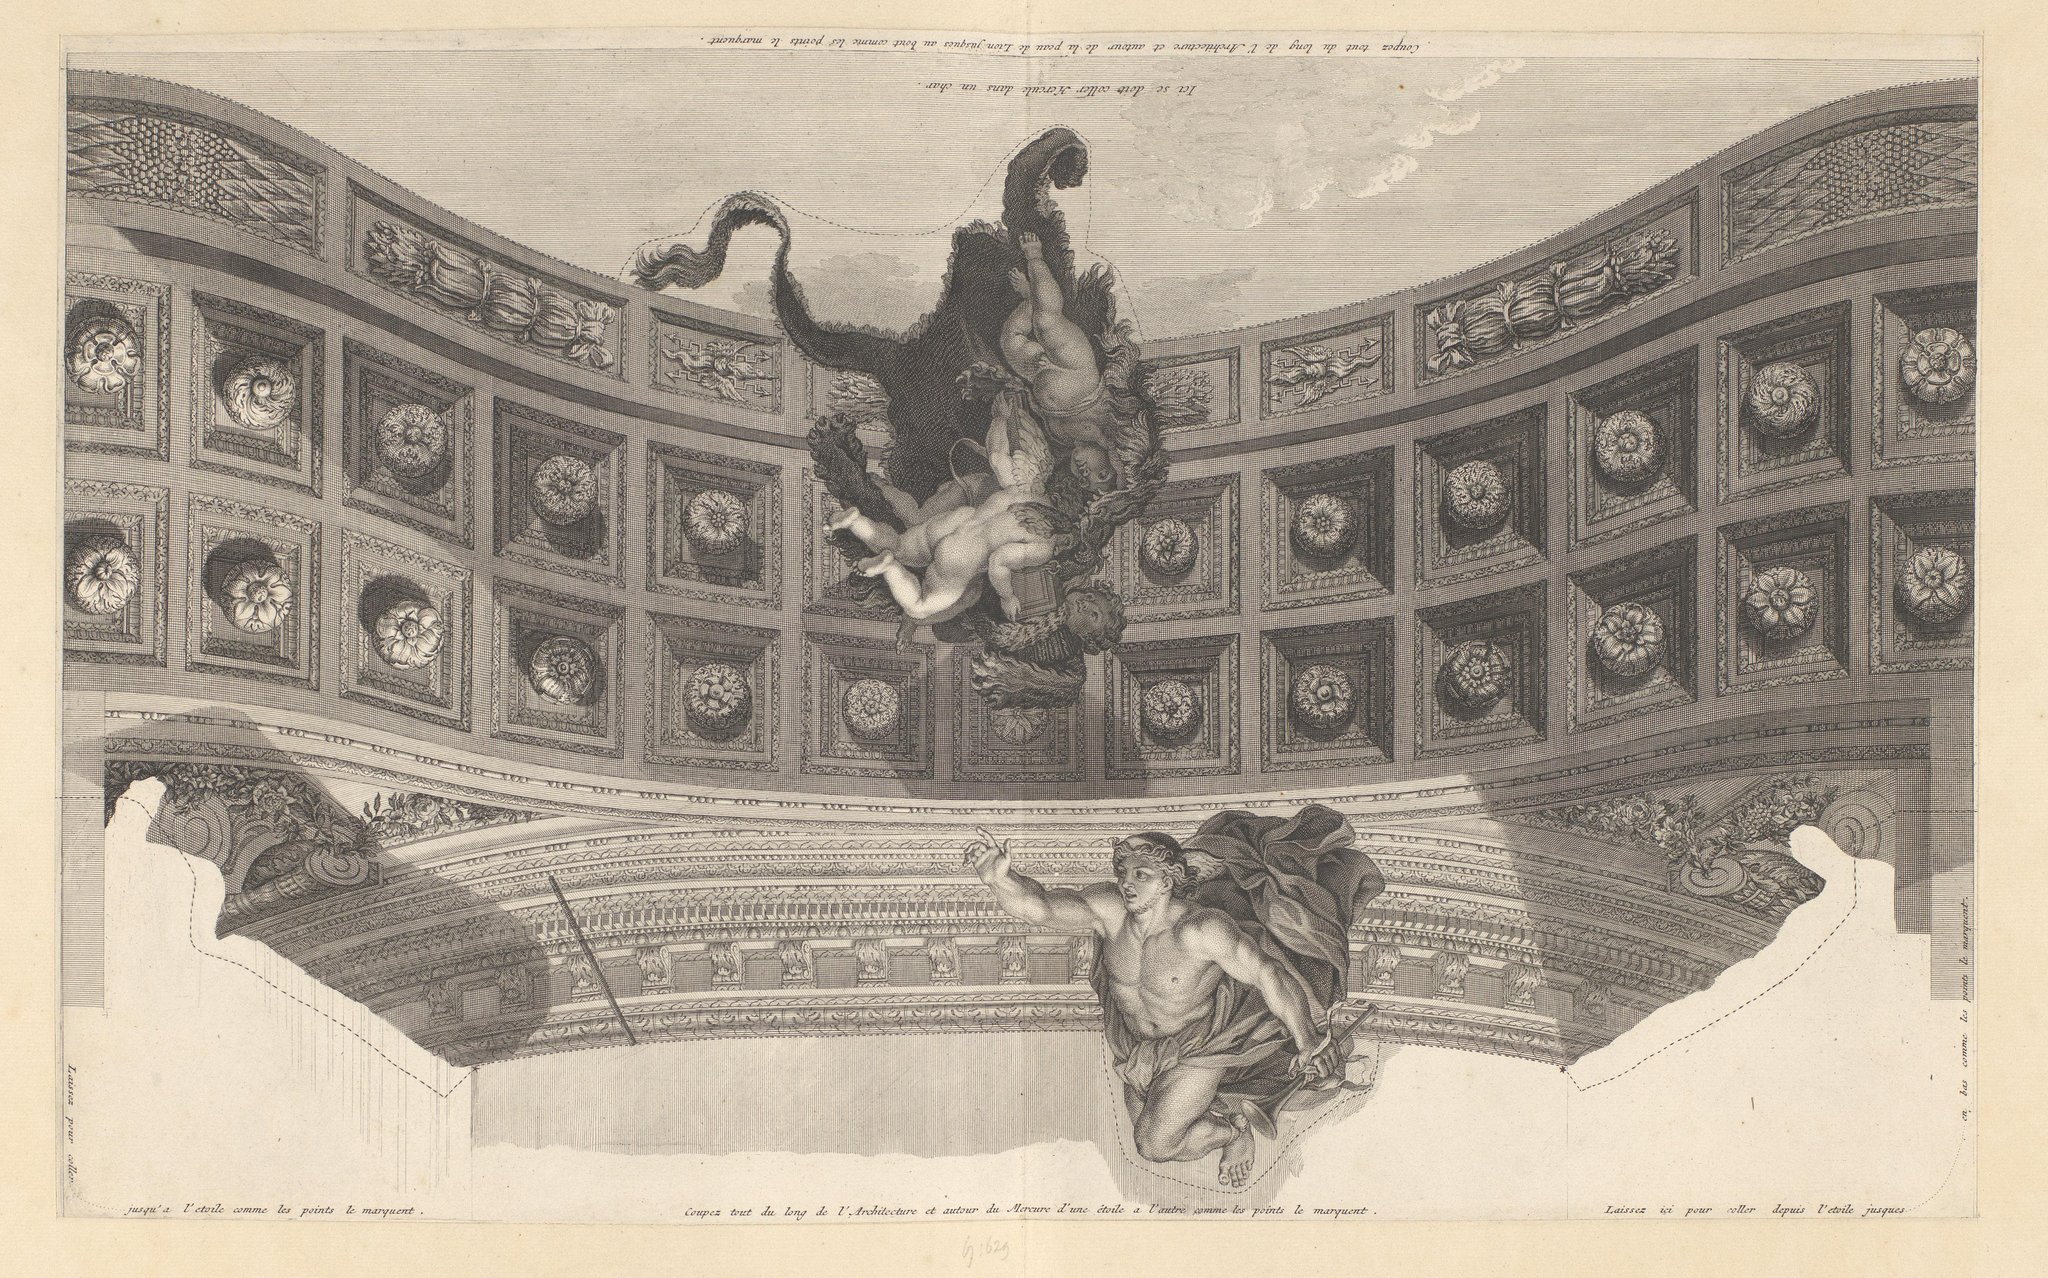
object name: album leaf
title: Mercurius met een trompet en putti die de huid van de Nemeïsche leeuw dragen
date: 1710-1720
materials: paper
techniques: engraving, etching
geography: amsterdam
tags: nemean lion, cupids: 'amores', 'amoretti', 'putti'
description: Mercurius, de boodschapper van de goden, komt aanvliegen met een trompet in zijn hand. Putti dragen de huid van de door Hercules overwonnen Nemeïsche leeuw. Langs de randen instructies voor het monteren van de prent aan andere prenten. Prent maakt deel uit van een serie prenten, die samen het geschilderde plafond met de Apotheose van Hercules in het Hôtel Lambert te Parijs voorstellen. Deze prent maakt deel uit van een album.